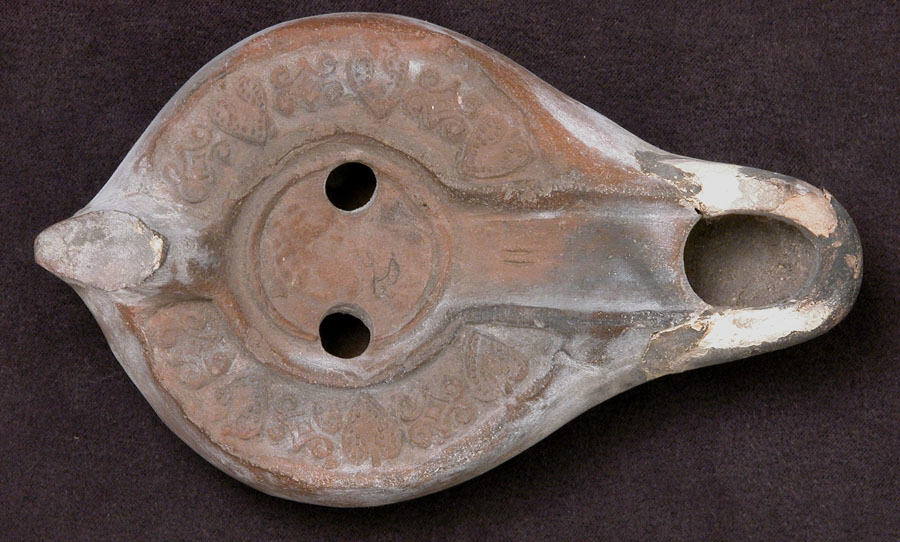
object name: lamp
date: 401-600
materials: earthenware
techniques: molding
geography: egypt